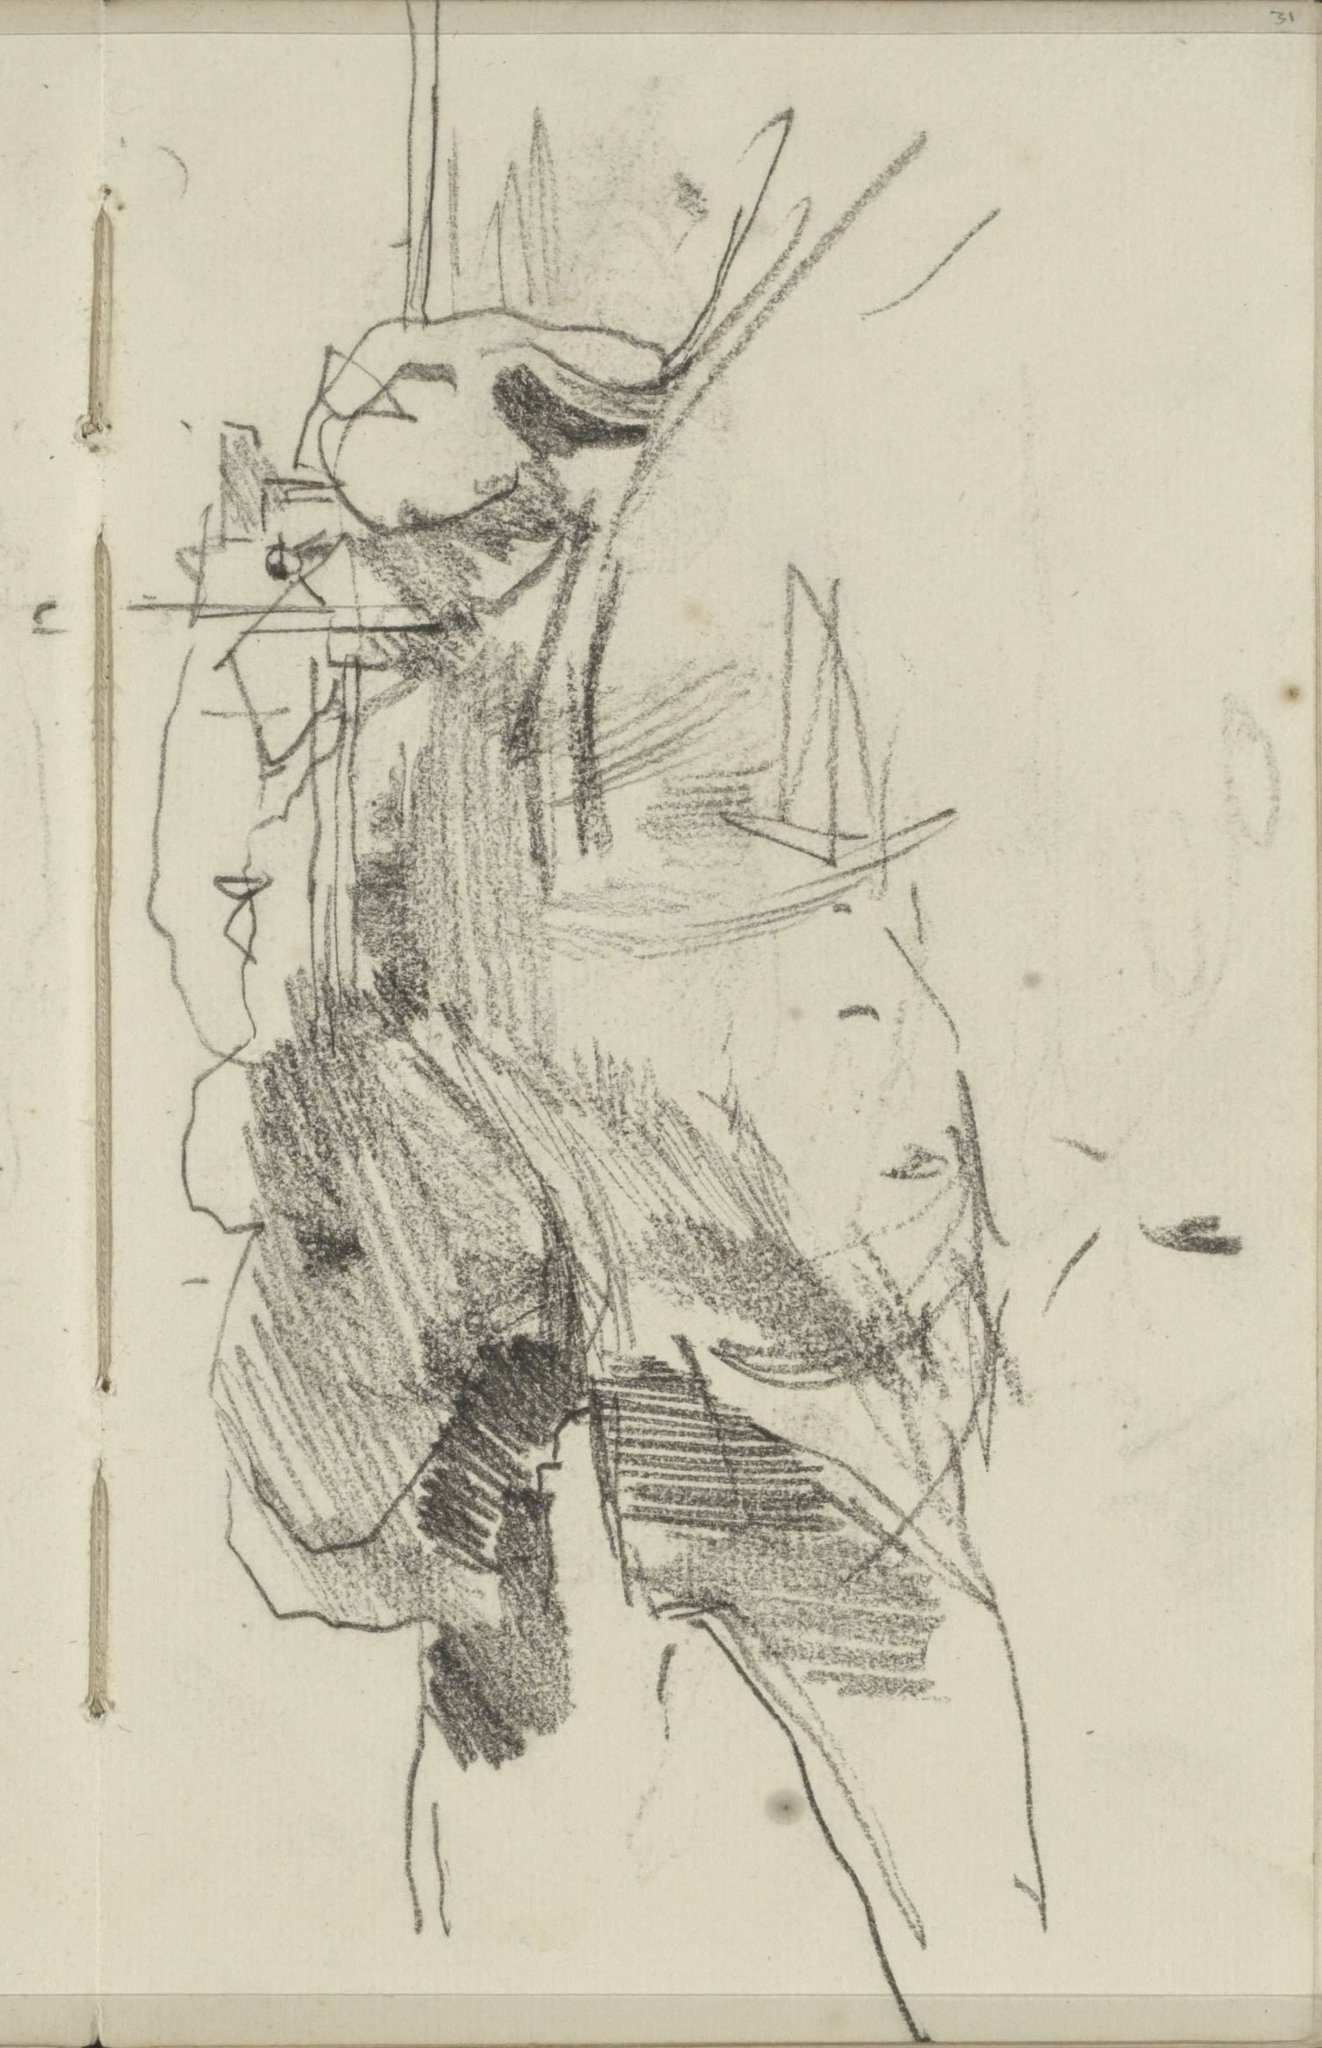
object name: sketchbook leaf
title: Figuur in een landschap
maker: george hendrik breitner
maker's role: draughtsman, painter, print maker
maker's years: 1857-1923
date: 1880-1882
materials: chalk, paper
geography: the hague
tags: landscapes with waters, waterscapes, seascapes (in the temperate zone), landscapes (+ landscape with figures, staffage)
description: Links mogelijk water. Pagina 31 uit een schetsboek met 25 bladen.